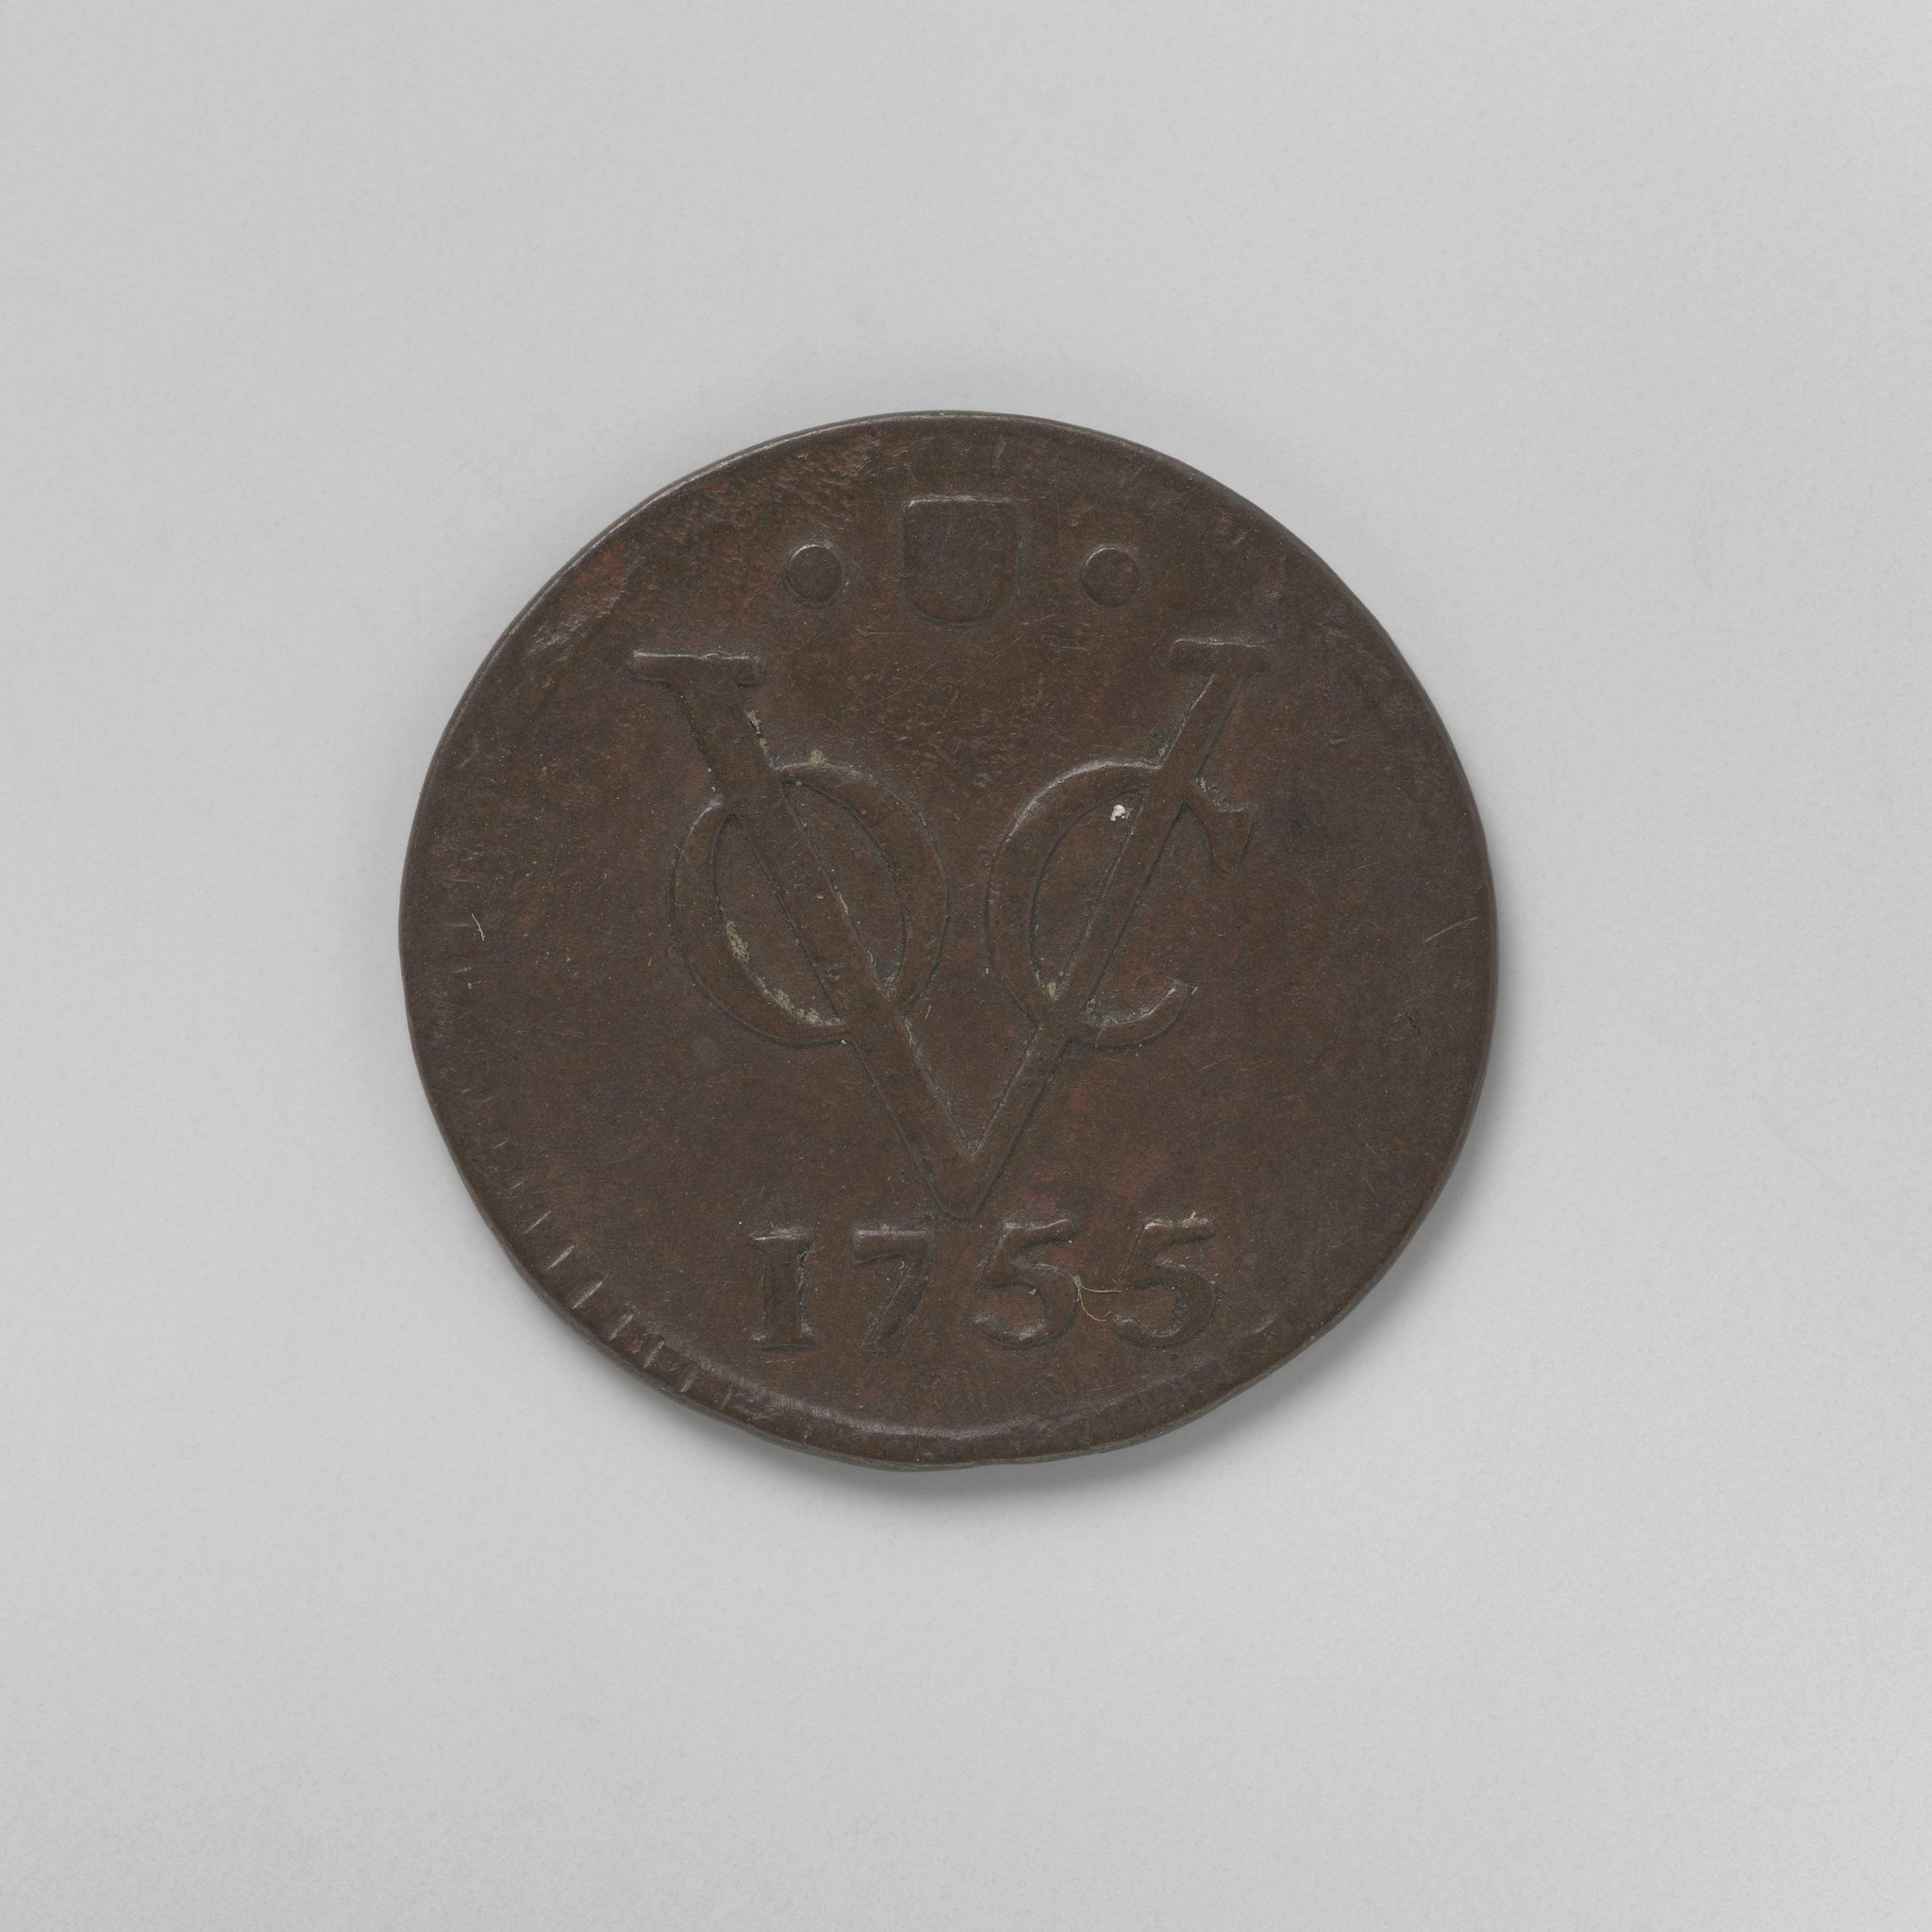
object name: coin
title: VOC, ½ duit stad Utrecht,1755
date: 1755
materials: copper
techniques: striking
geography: utrecht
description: Koperen munt. Voorzijde: gekroond ingebogen wapenschild van de stad Utrecht. Keerzijde: monogram van de VOC, waarboven muntteken en waaronder jaartal. Gladde rand.